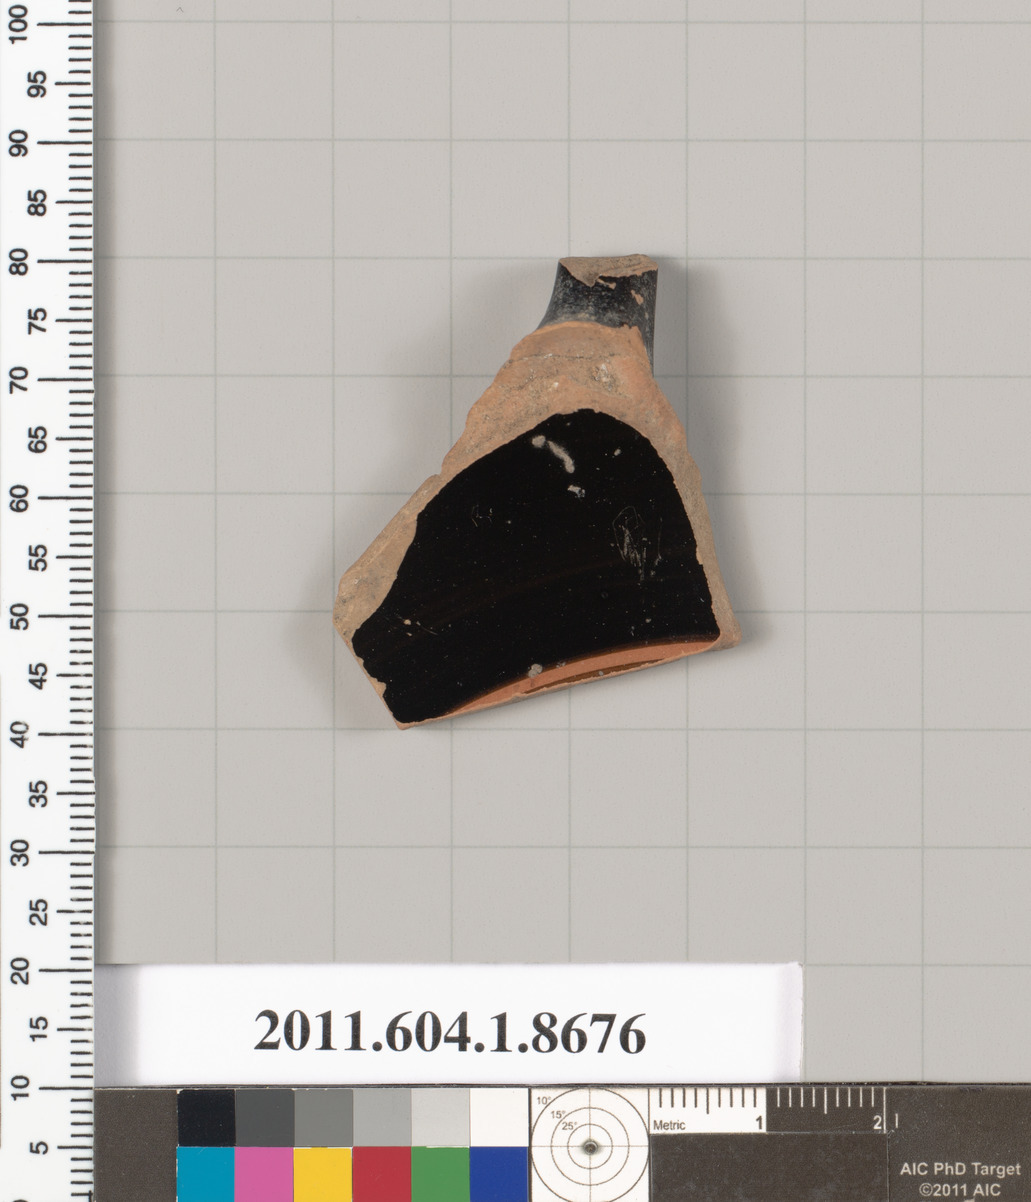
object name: kylix fragment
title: Terracotta fragment of a stemless kylix (drinking cup)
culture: greek, attic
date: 460-450 BCE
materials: terracotta